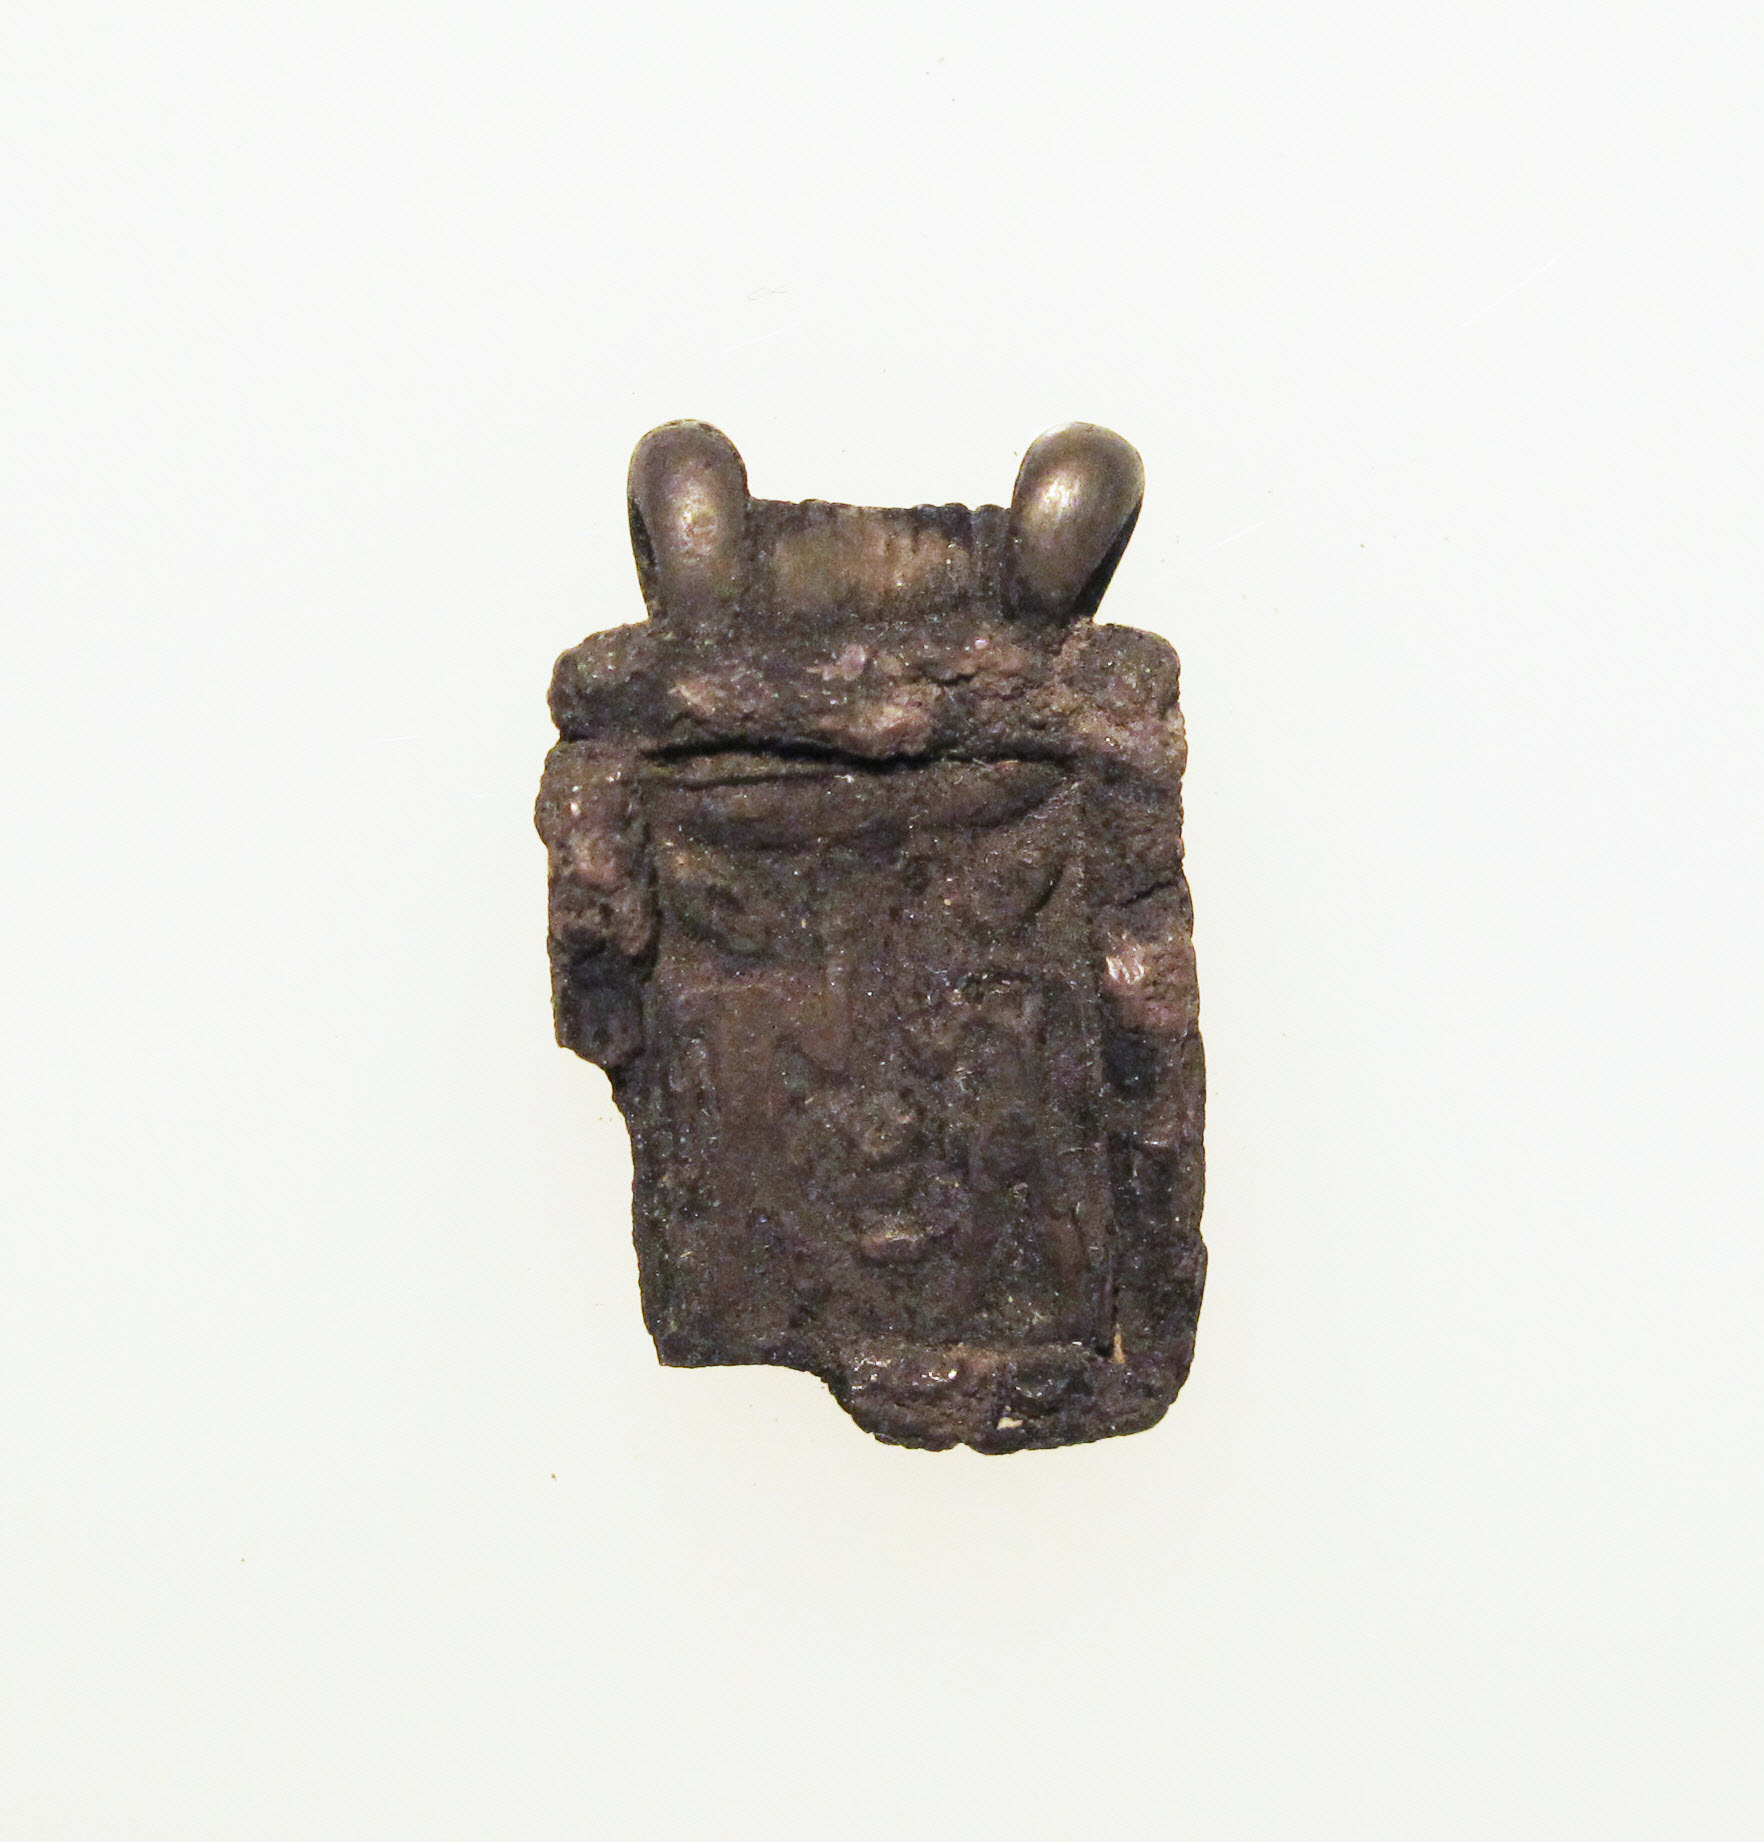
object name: figure pendant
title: Silver pendant with figures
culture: cypriot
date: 3900 BCE-100 CE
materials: silver